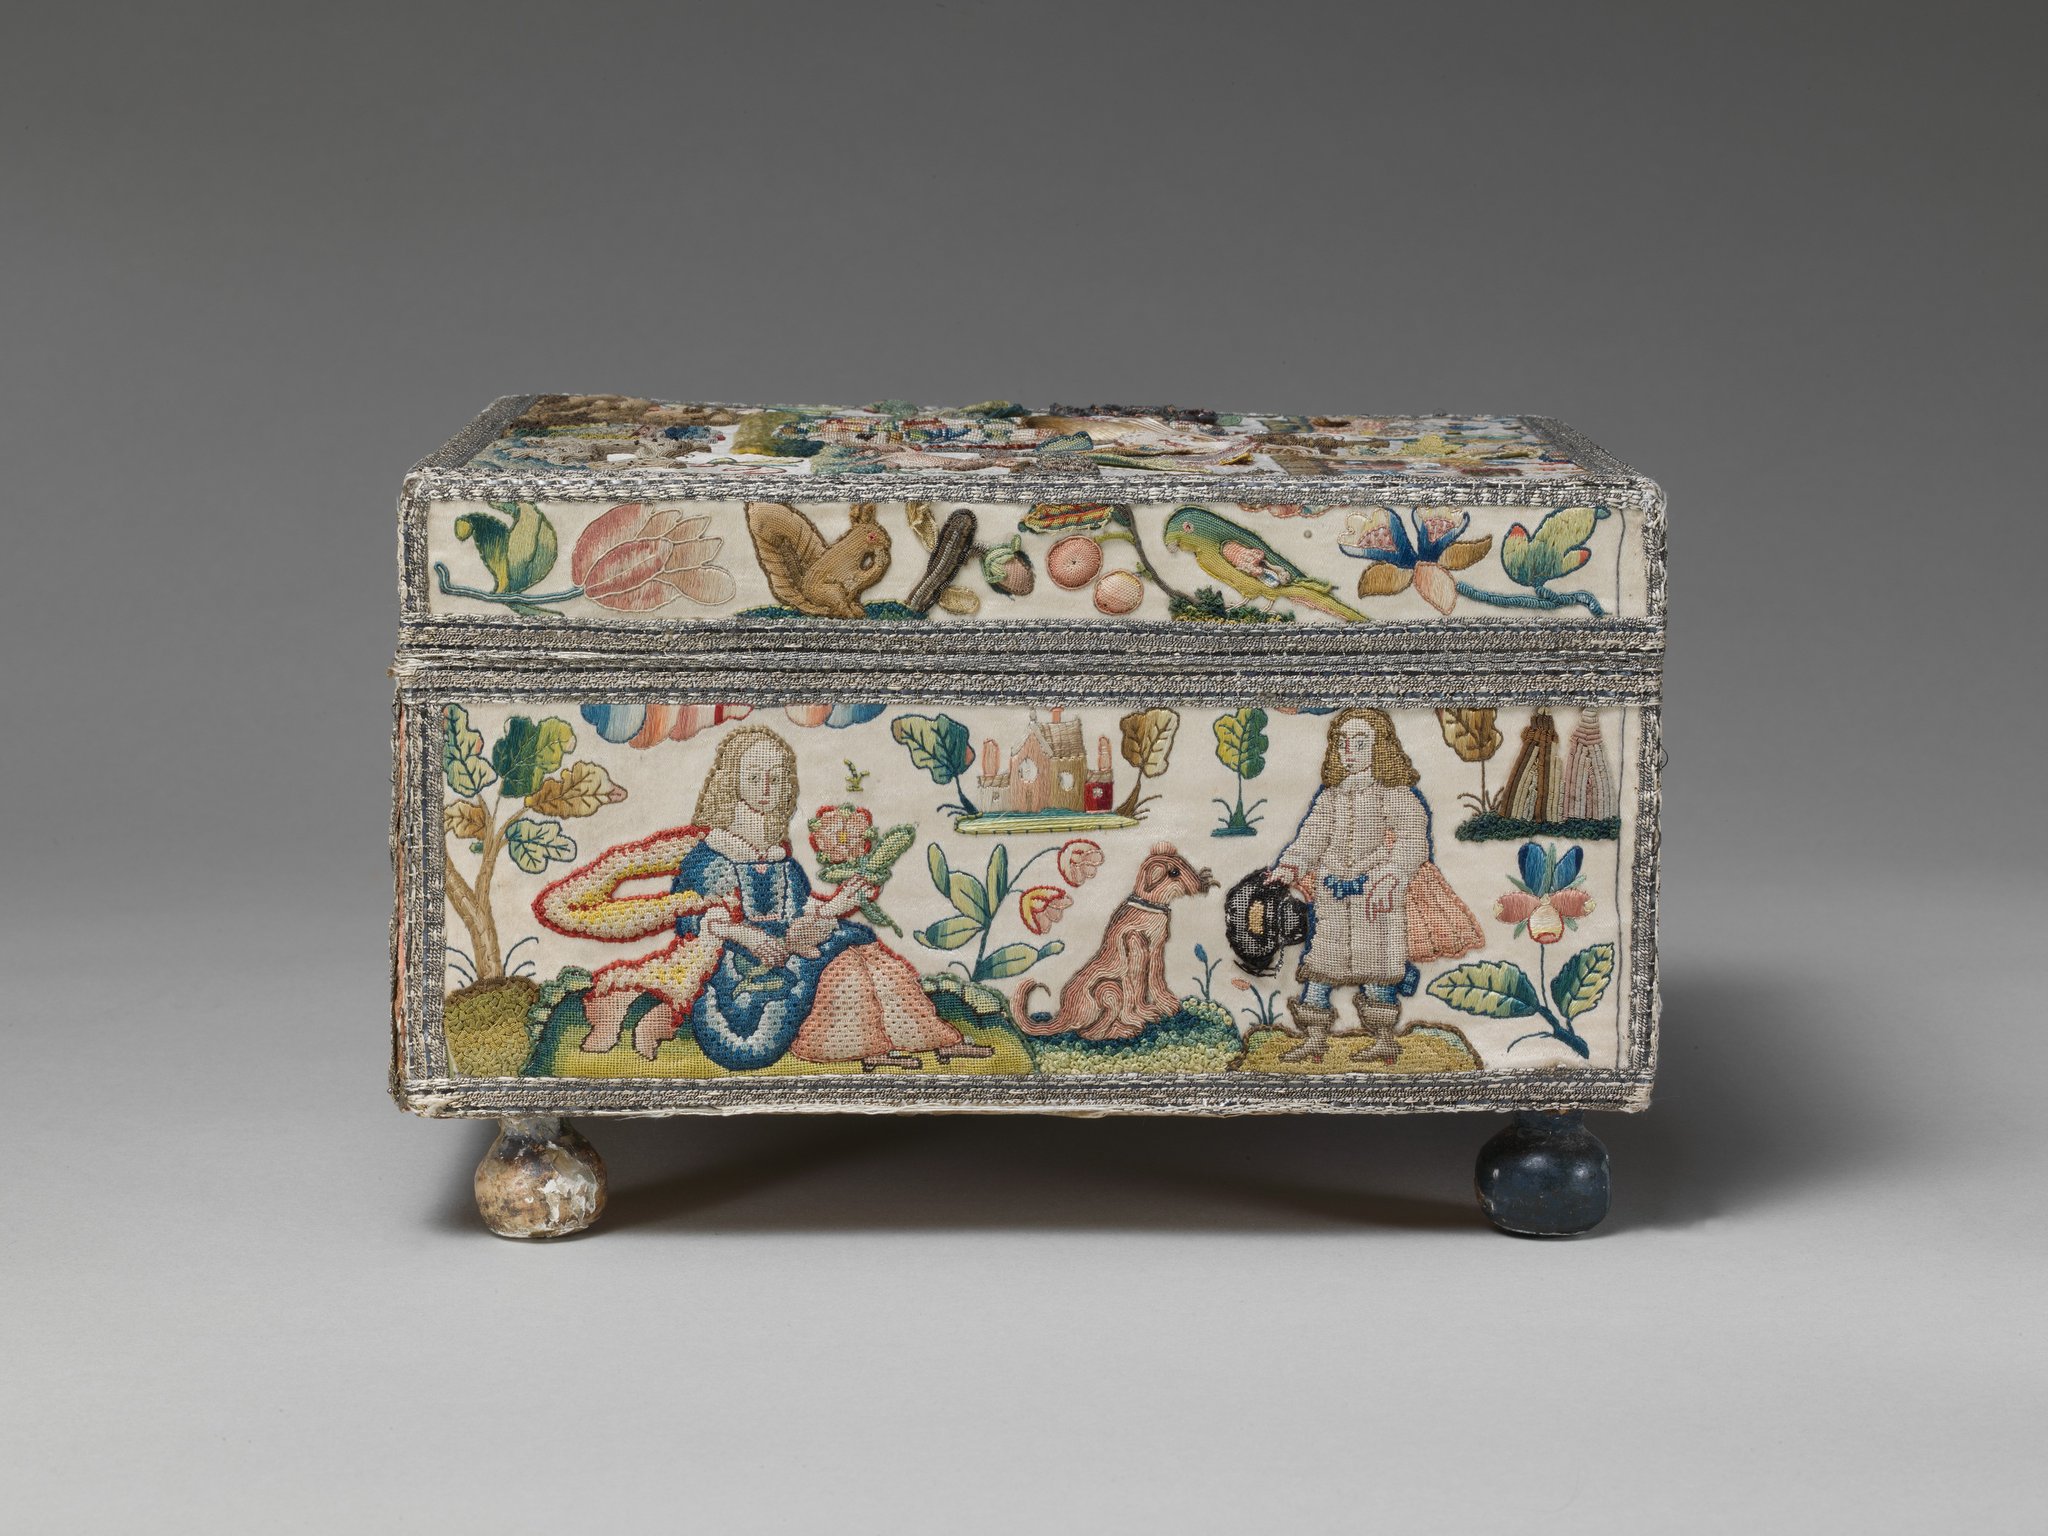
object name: cabinet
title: Cabinet with personifications of the Five Senses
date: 1651-1675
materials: coral, metal thread, mica, paper, pearl, textile, silk, wood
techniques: embroidery, lining, stitching, weave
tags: birds,eagles,castles,houses,men,women,lutes,cats,deer,dogs,insects,monkeys,rabbits,squirrels,turtles,flowers,trees,coat of arms